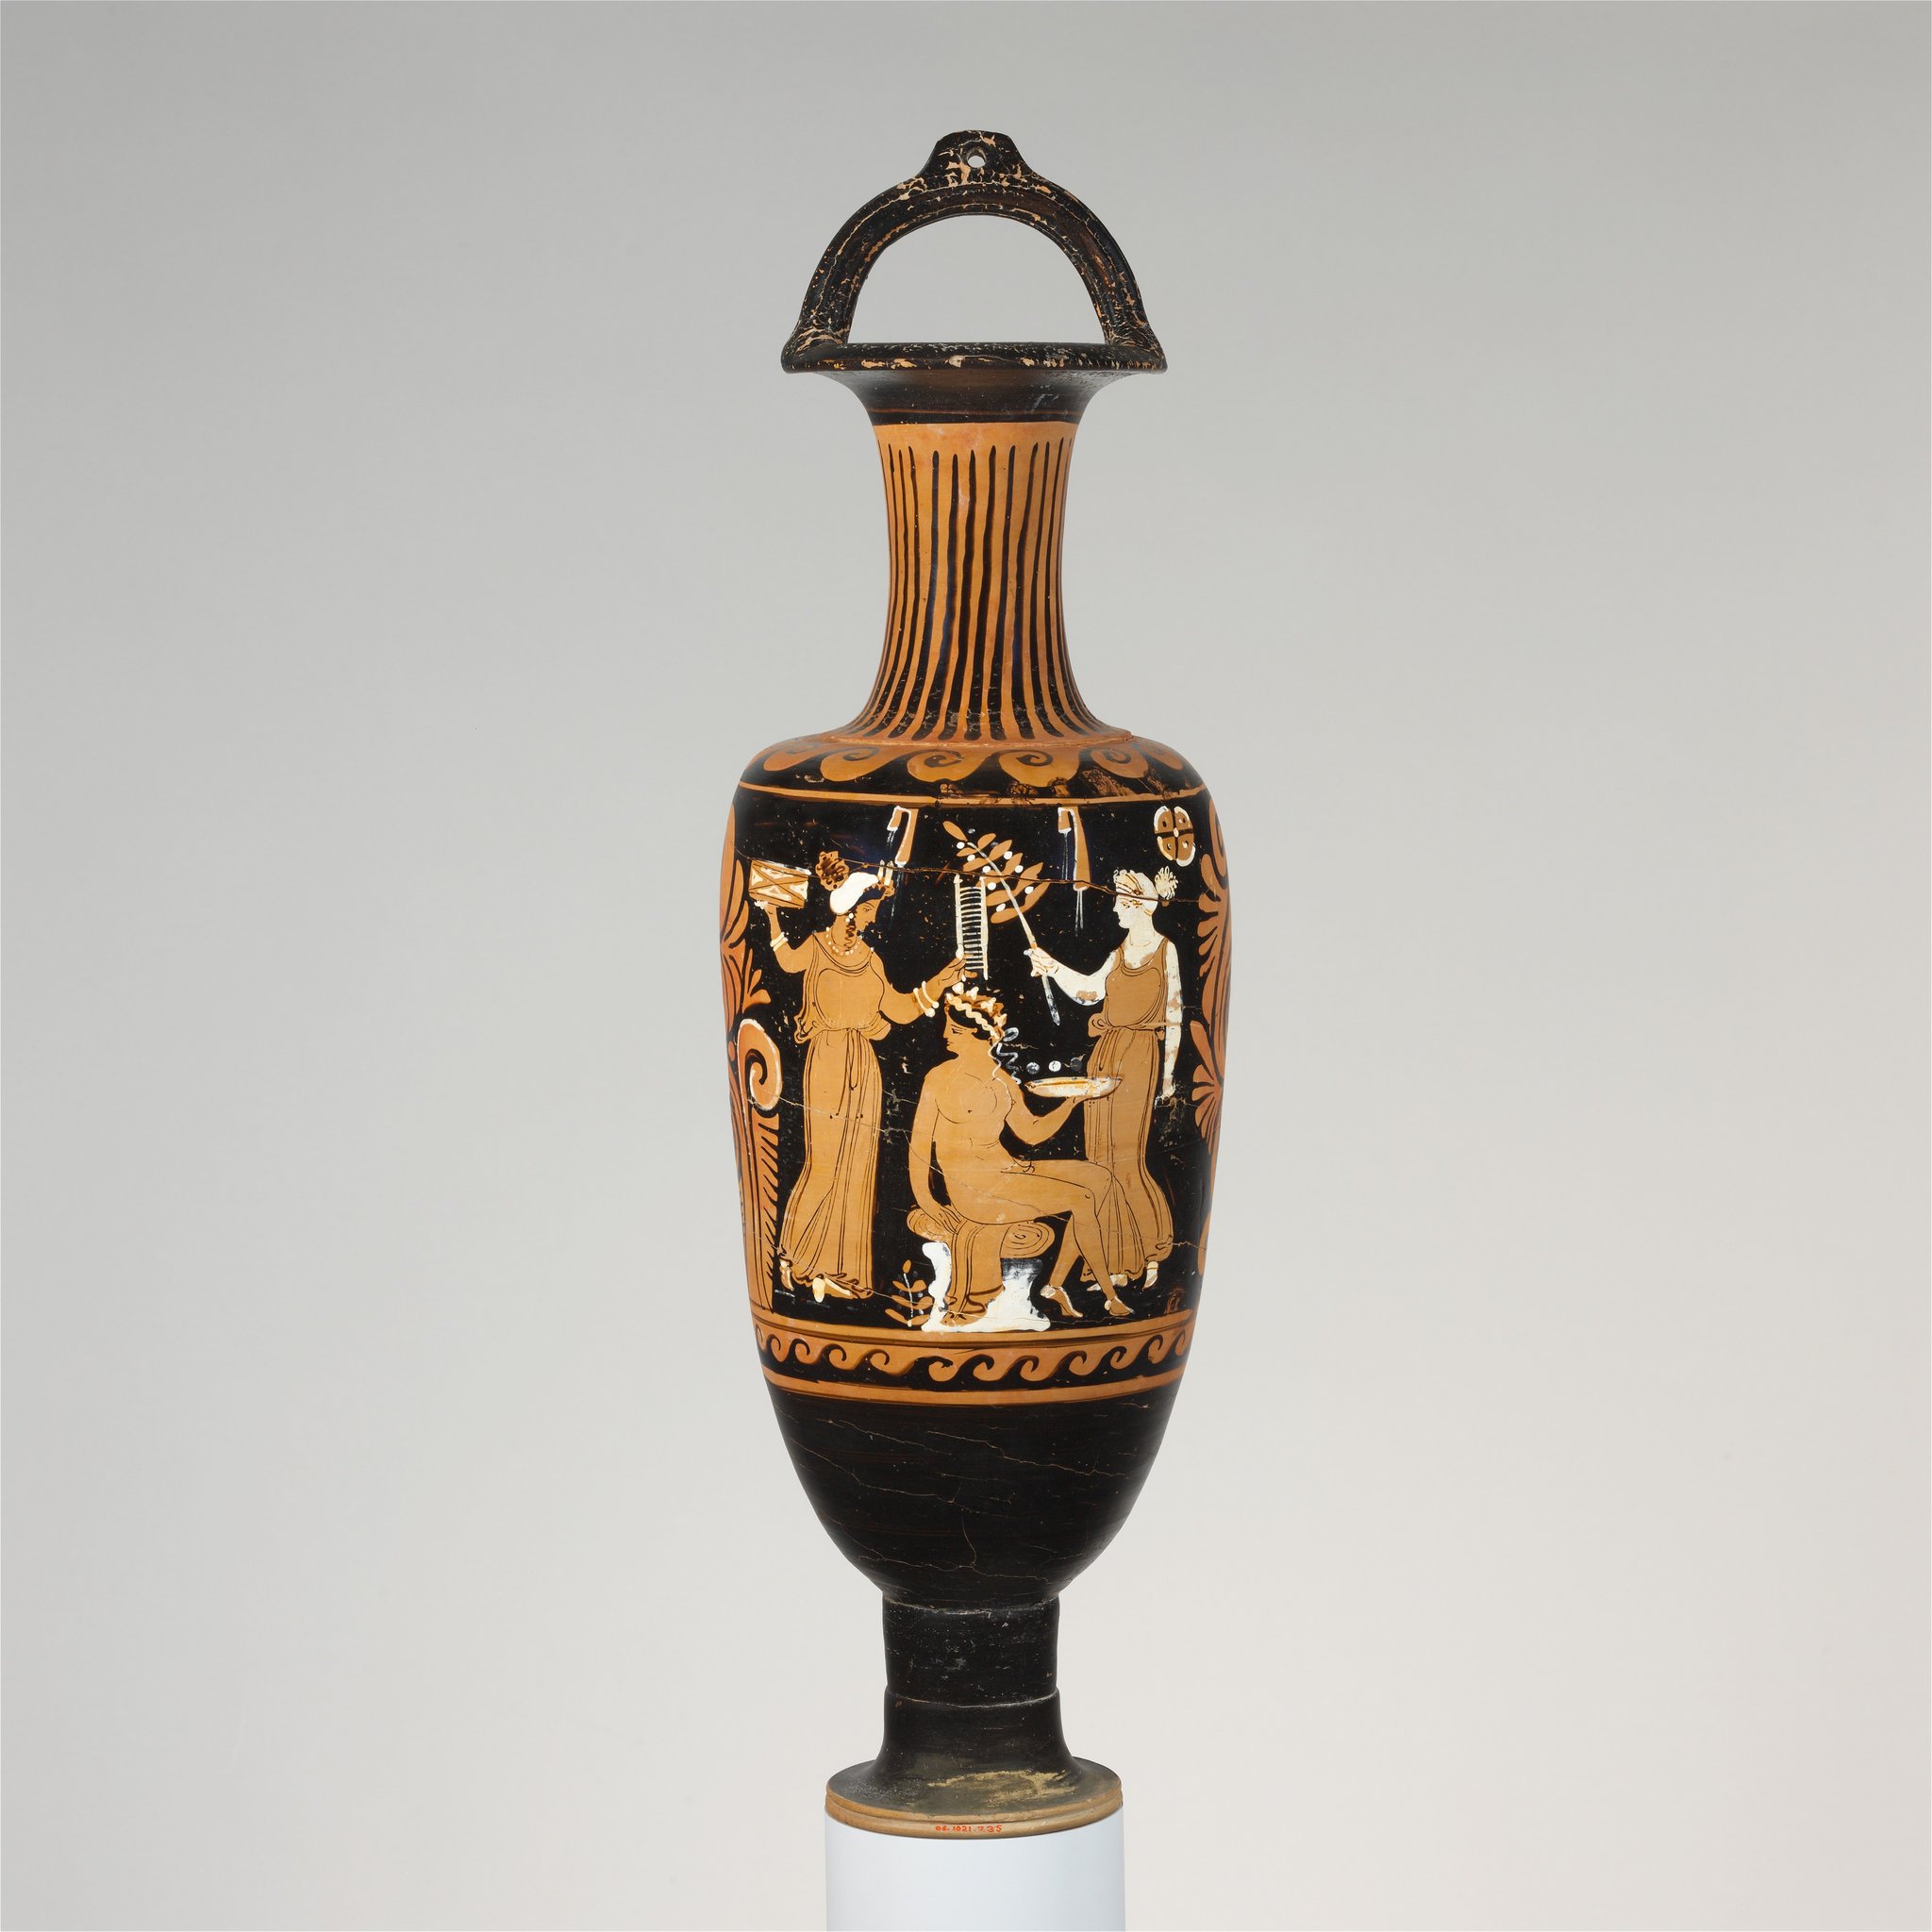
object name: bail amphora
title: Terracotta bail-amphora (jar)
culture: greek or south italian or campanian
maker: apz painter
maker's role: artist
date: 330-320 BCE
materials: terracotta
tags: male nudes,women